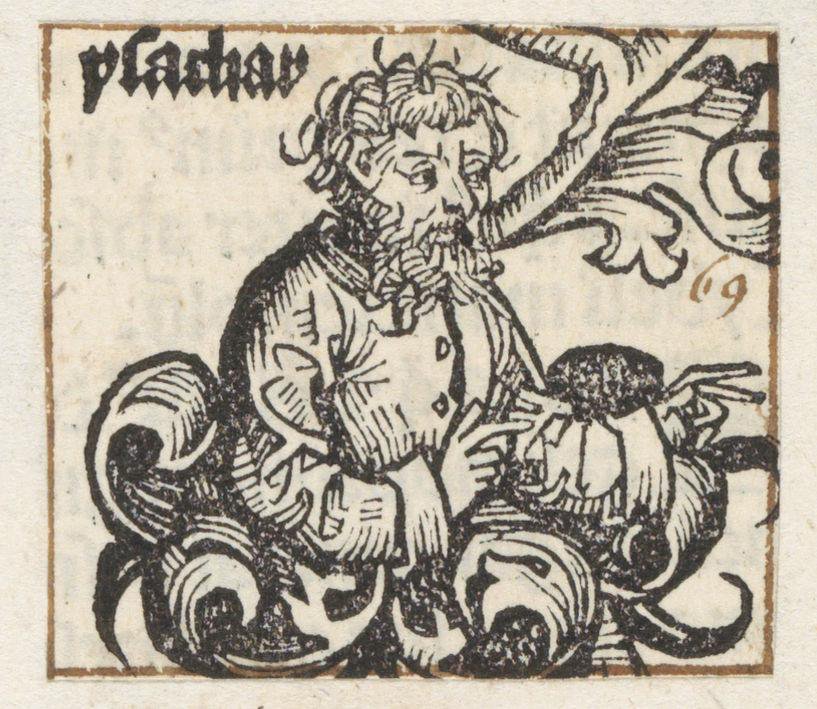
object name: album leaf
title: Ysachar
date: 1493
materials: paper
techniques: letterpress printing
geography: nuremberg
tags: persons from the old testament (not in biblical context, nor occurring in legendary/historical extensions included in division 71)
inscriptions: inscription: ‘69’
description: Een bloemkelk met een man, naar rechts gekeerd. De tekst identificeert hem als Issachar, zoon van Jakob en Lea. De voorstelling is een fragment van de stamboom van Christus in de Liber Chronicarum. De prent maakt deel uit van een album.